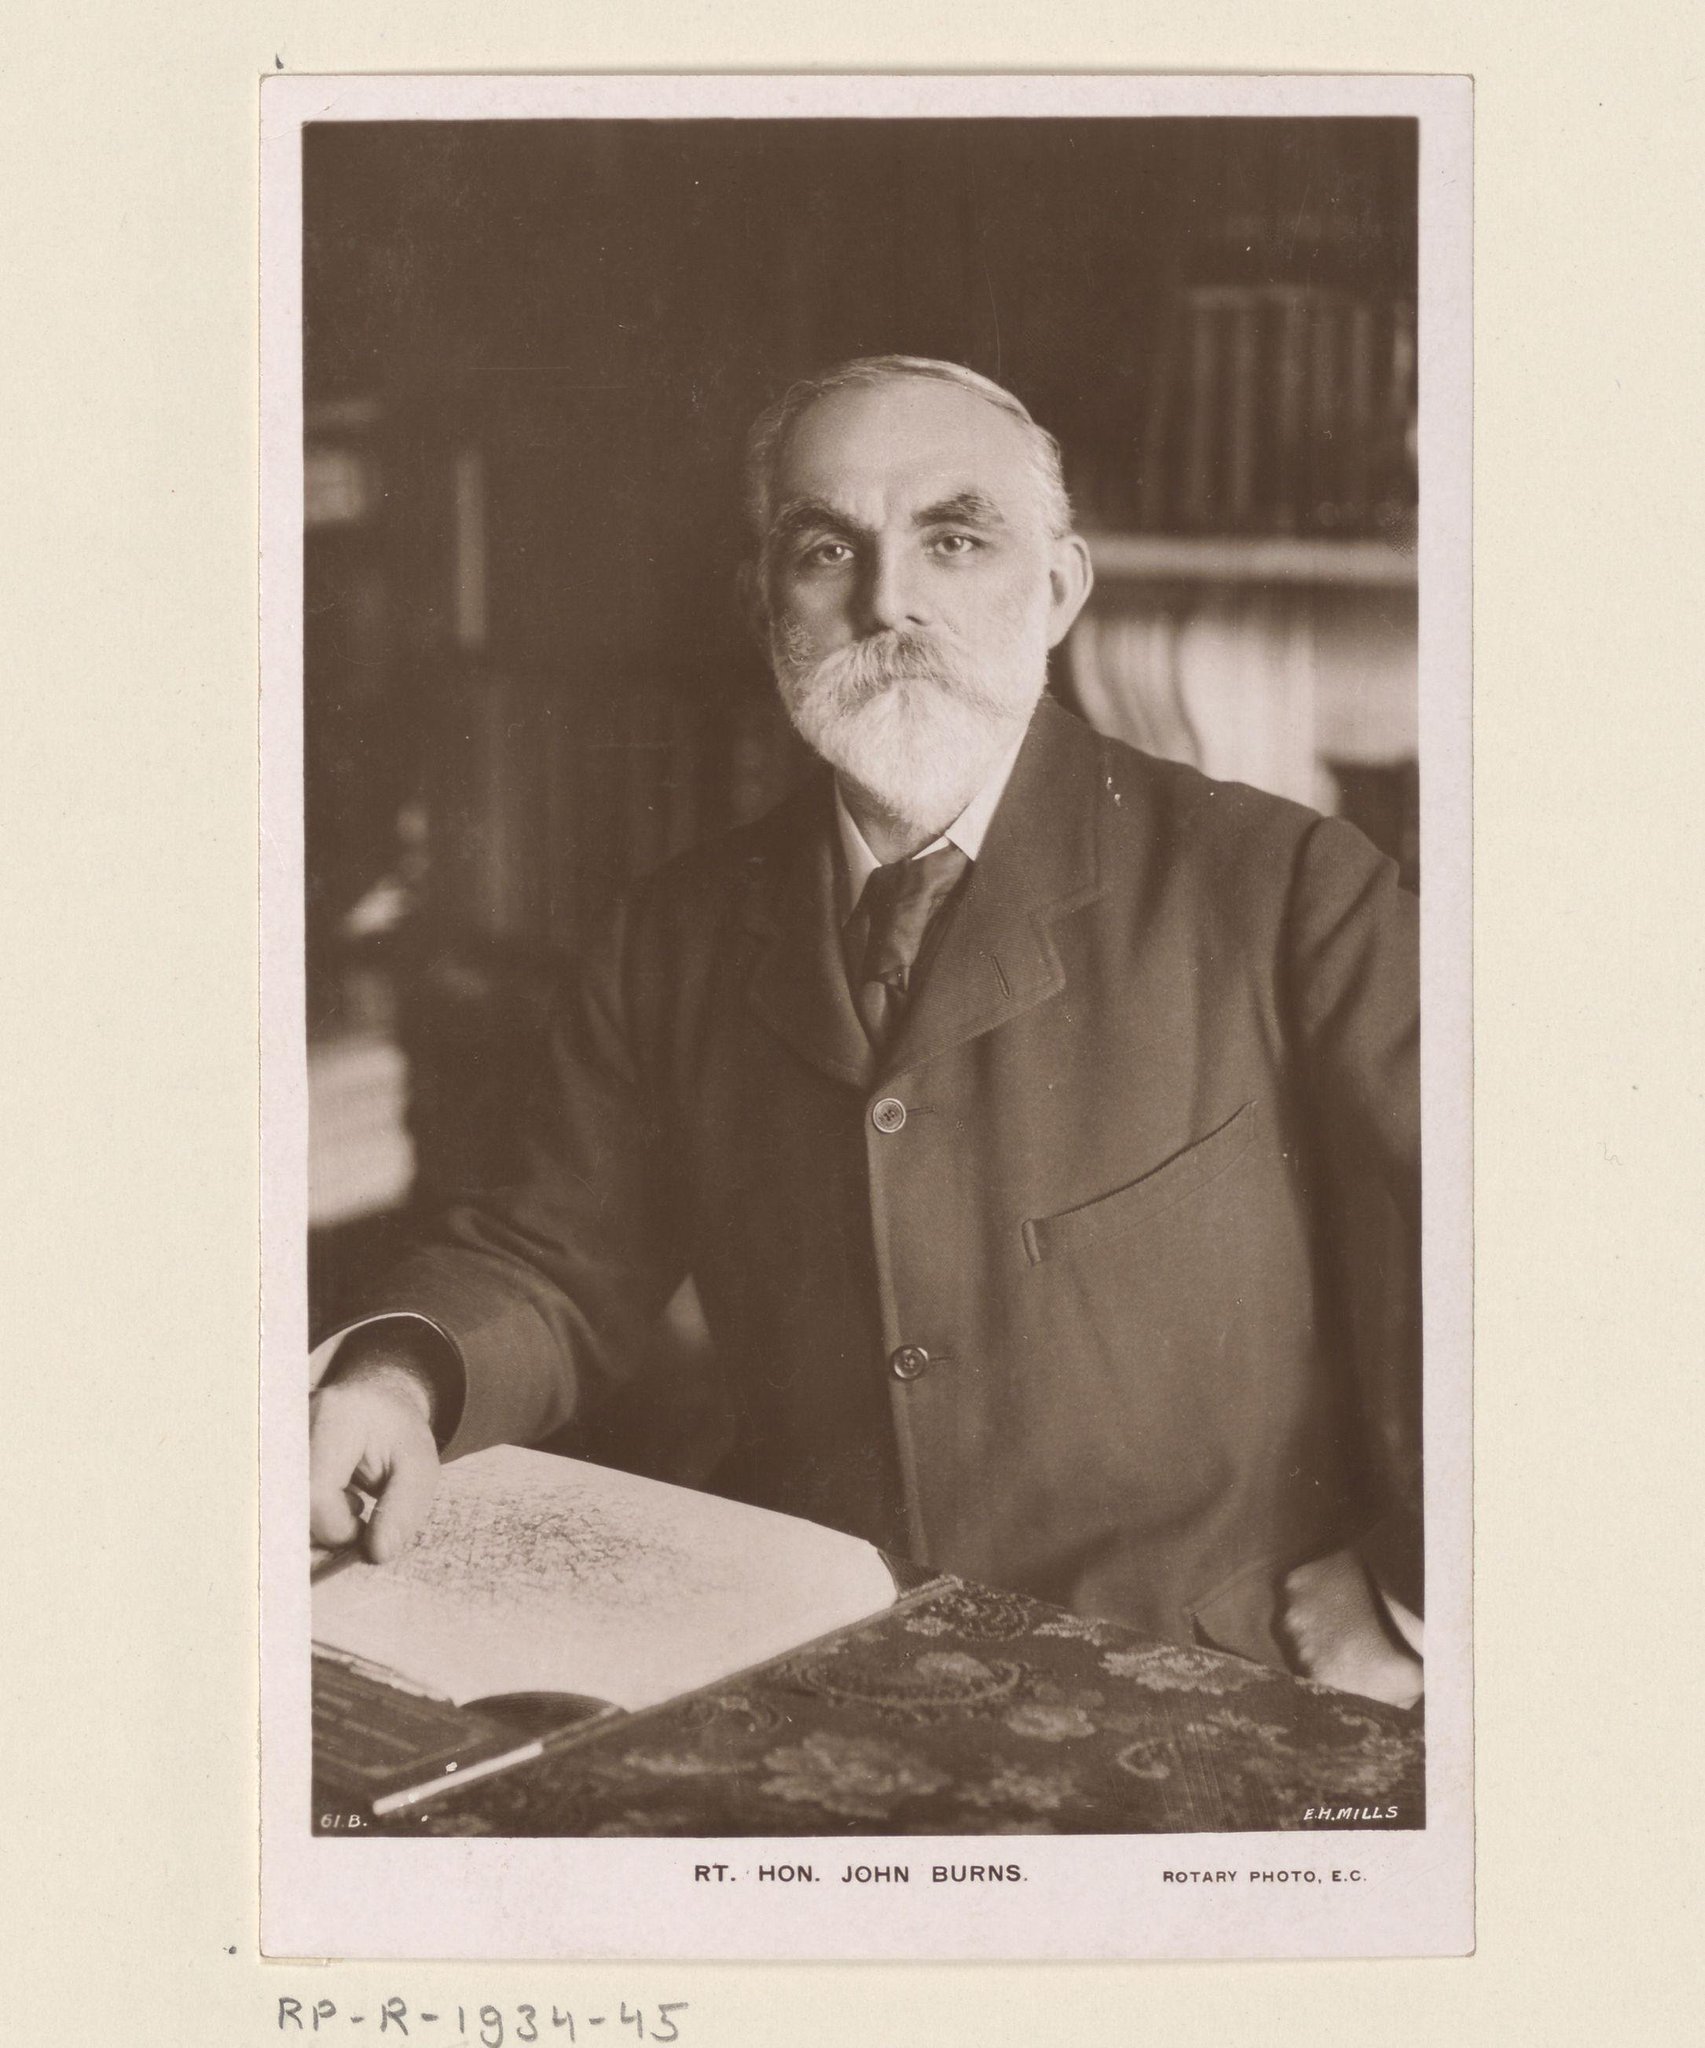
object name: photograph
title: Portret van John Burns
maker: ernest herbert mills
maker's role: fotograaf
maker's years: 1874-1942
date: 1897-1916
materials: photographic support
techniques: gelatin silver print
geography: london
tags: politician, historical persons, politician, e.g. party leader